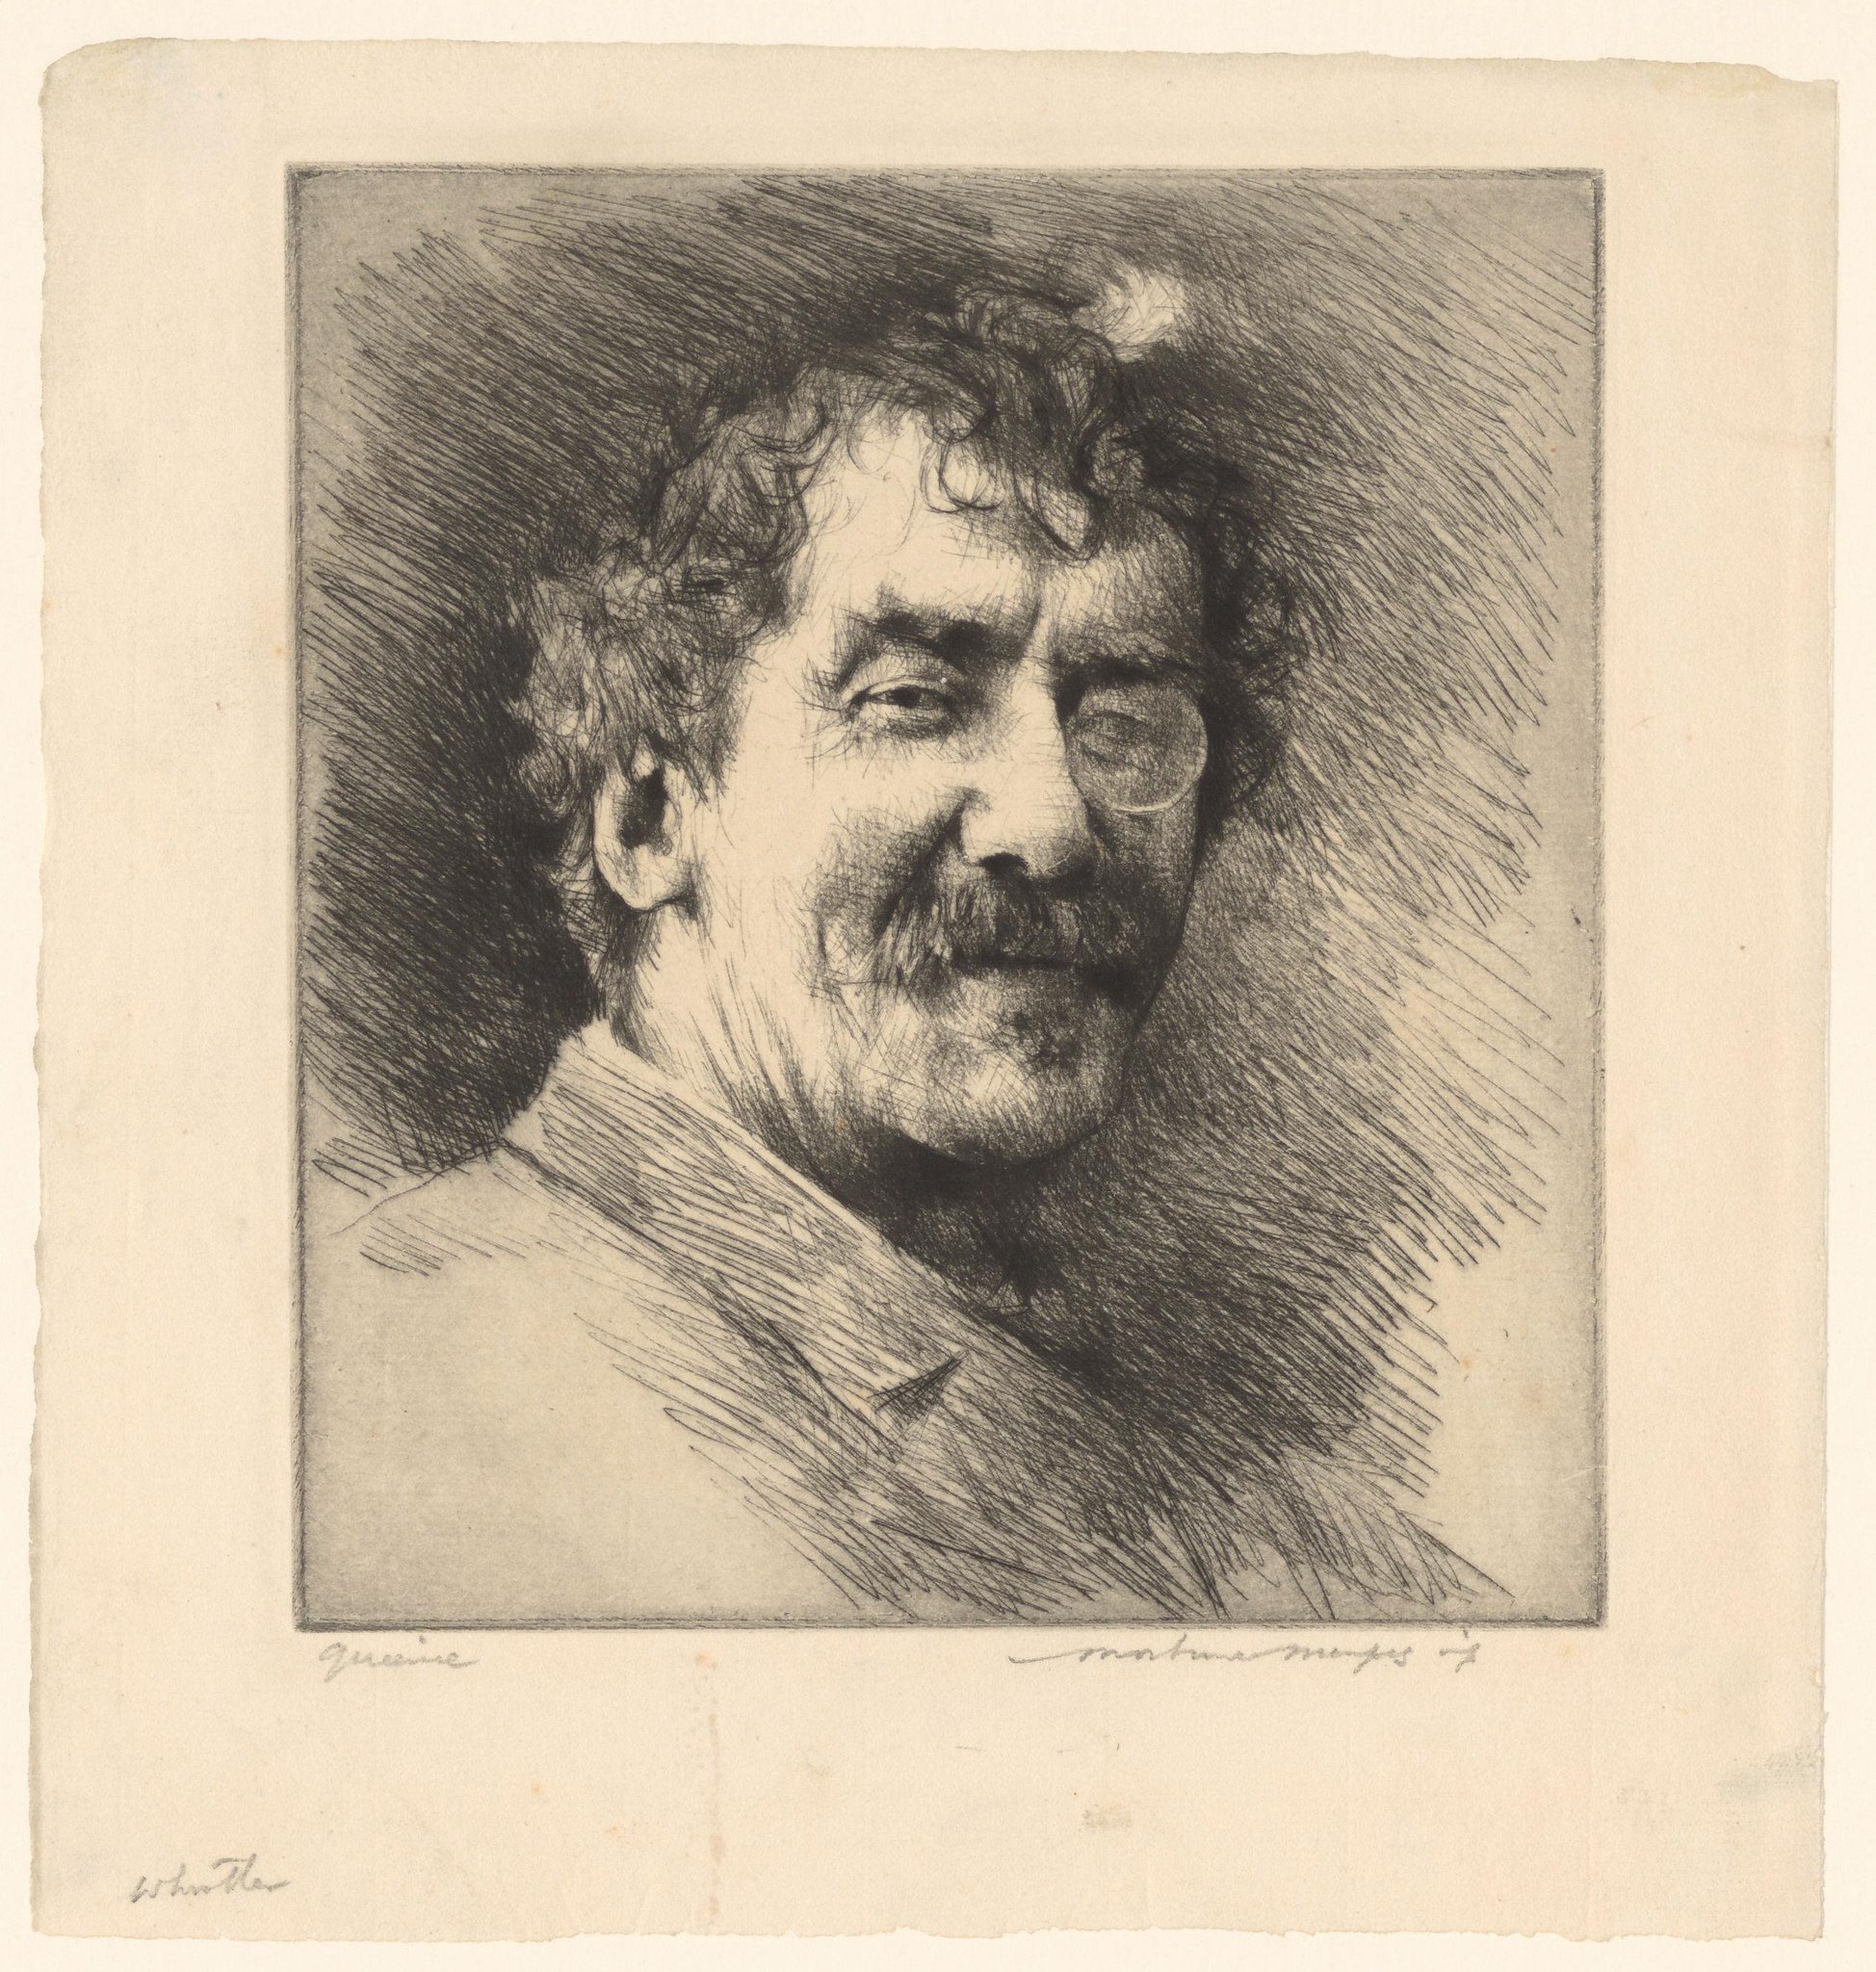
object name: print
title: Portrait of Whistler No. 9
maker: mortimer l. menpes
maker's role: print maker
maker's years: 1855-1938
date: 1912-1913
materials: paper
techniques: drypoint, etching, intaglio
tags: painter, james abbott mcneill whistler, monocle, single lorgnette, historical persons, portrait, self-portrait of painter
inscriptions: collector's mark: Lugt 2228, collector's mark: Lugt 2760, inscription: ‘Queenie’